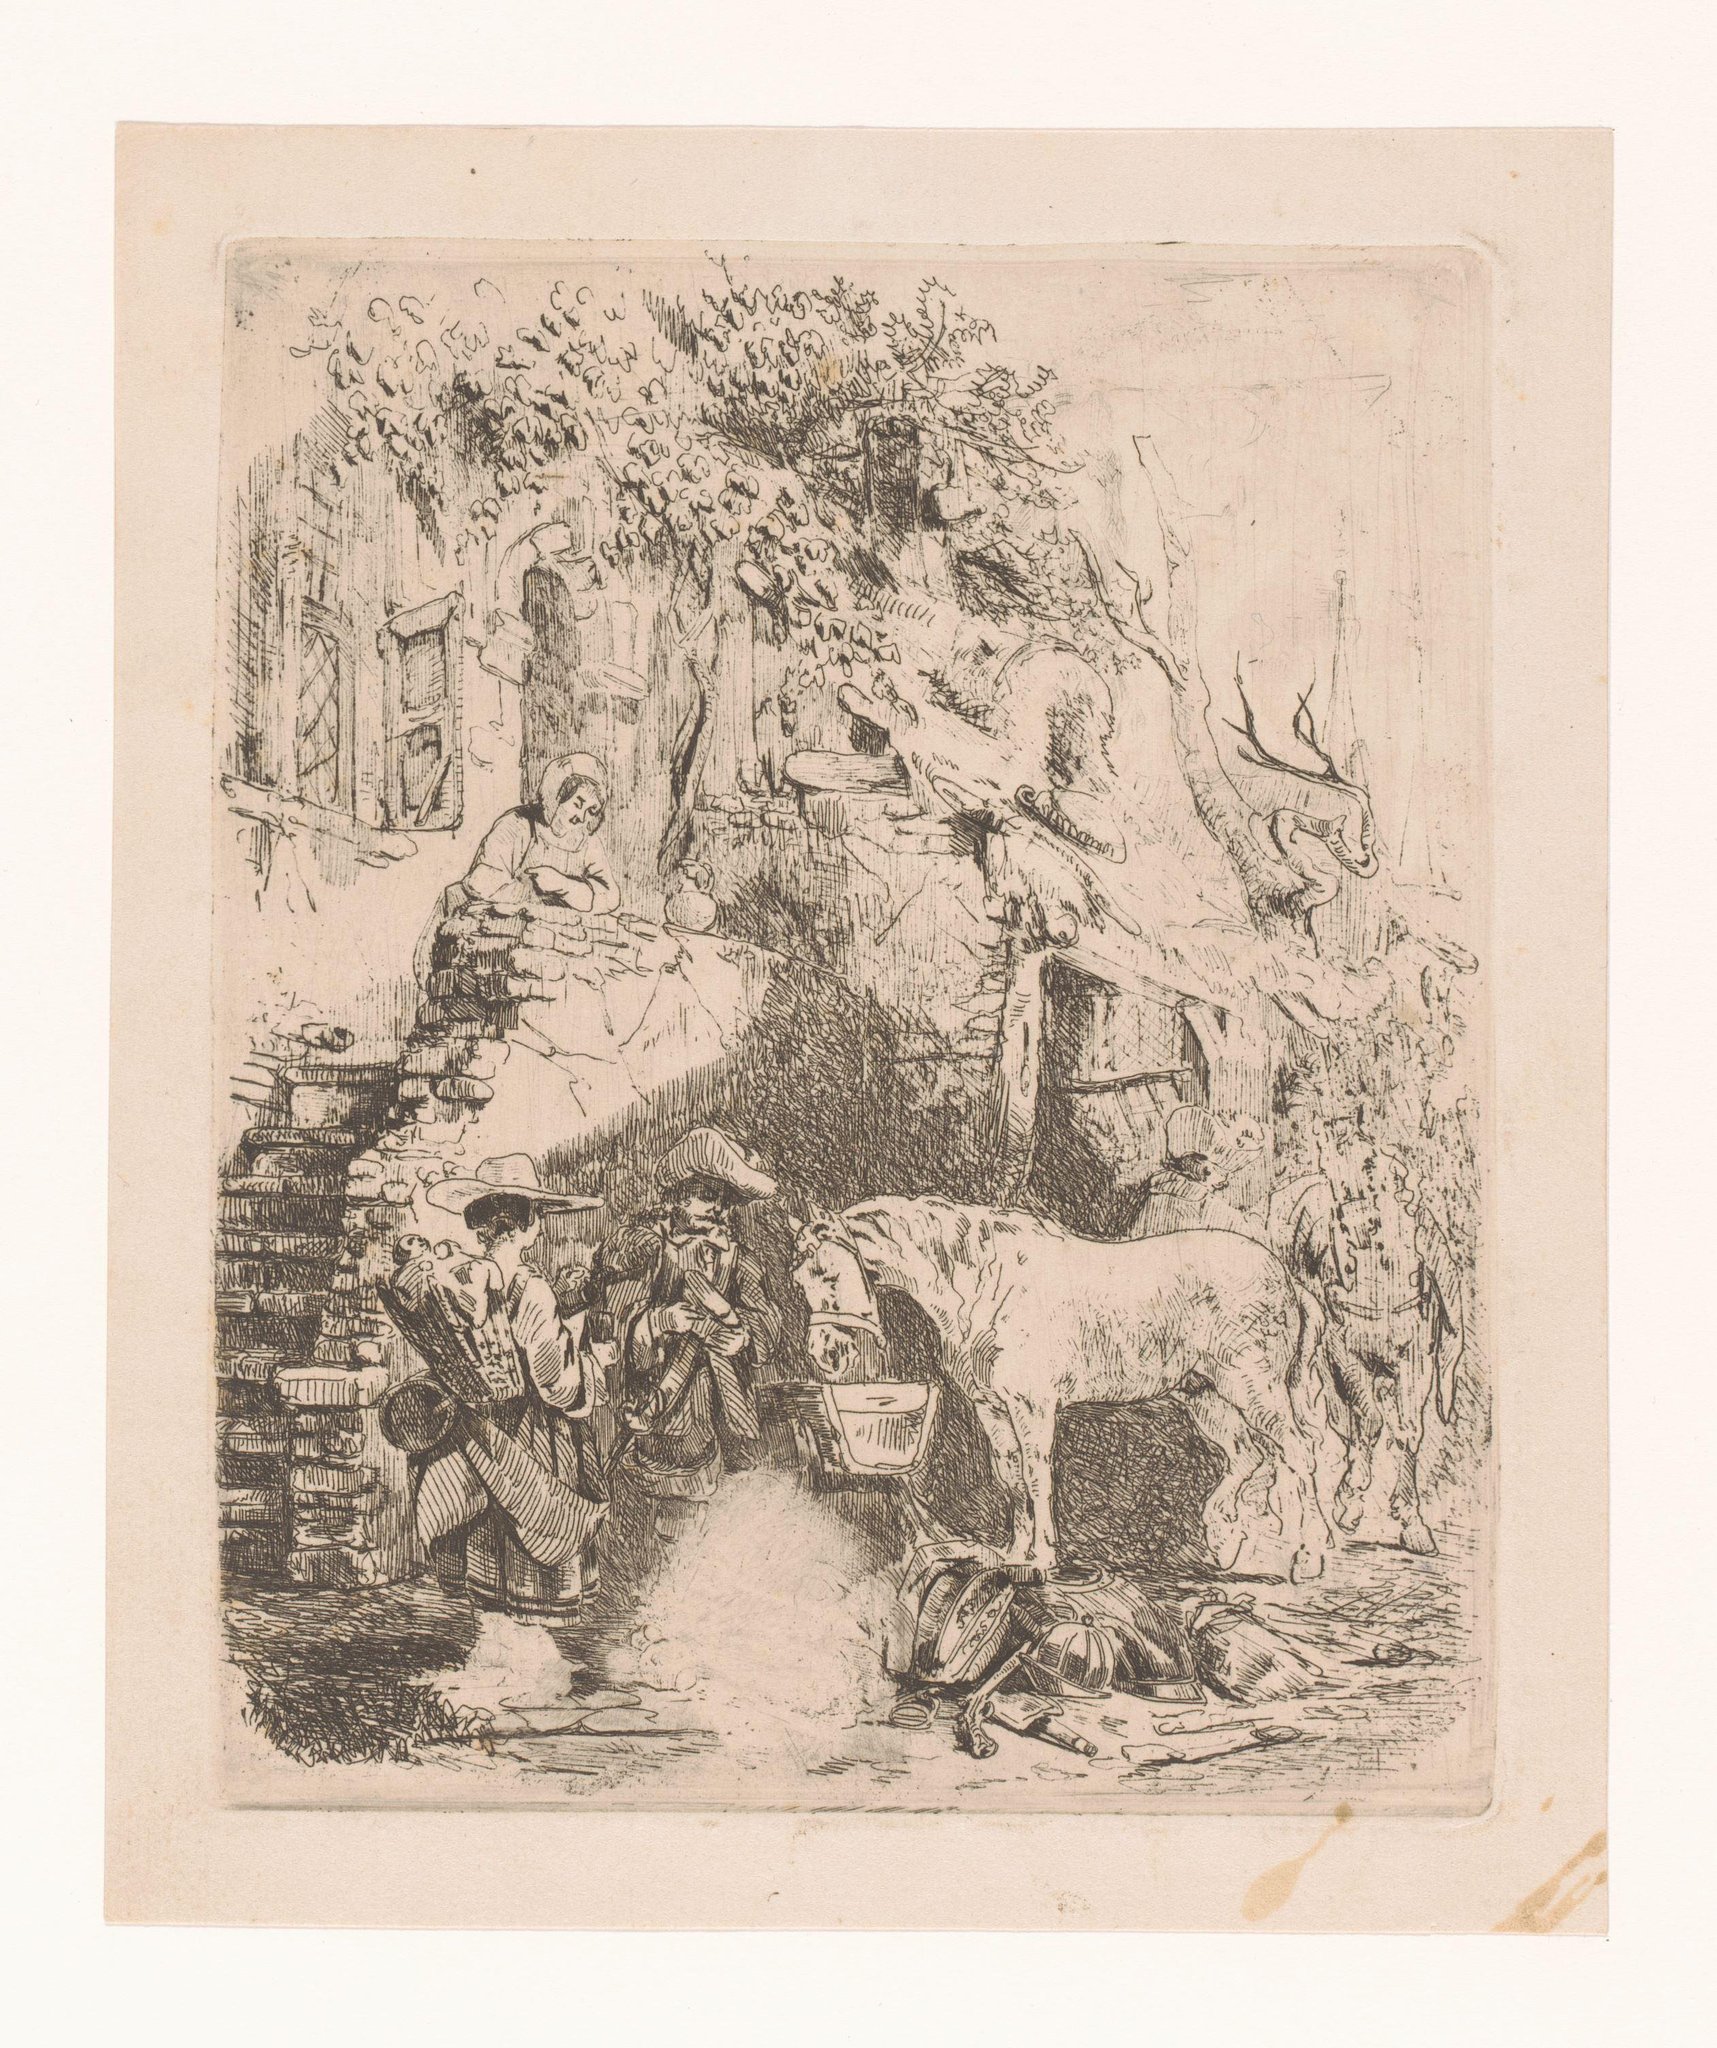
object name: print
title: Rustende ruiter voor een herberg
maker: adrien joseph verhoeven-ball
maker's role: draughtsman, print maker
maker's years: 1824-1882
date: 1834-1882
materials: paper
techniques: drypoint, etching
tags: riding a horse, ass, or mule; rider, horseman, hotel, hostelry, inn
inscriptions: collector's mark: Lugt 2228, collector's mark: Lugt 1485